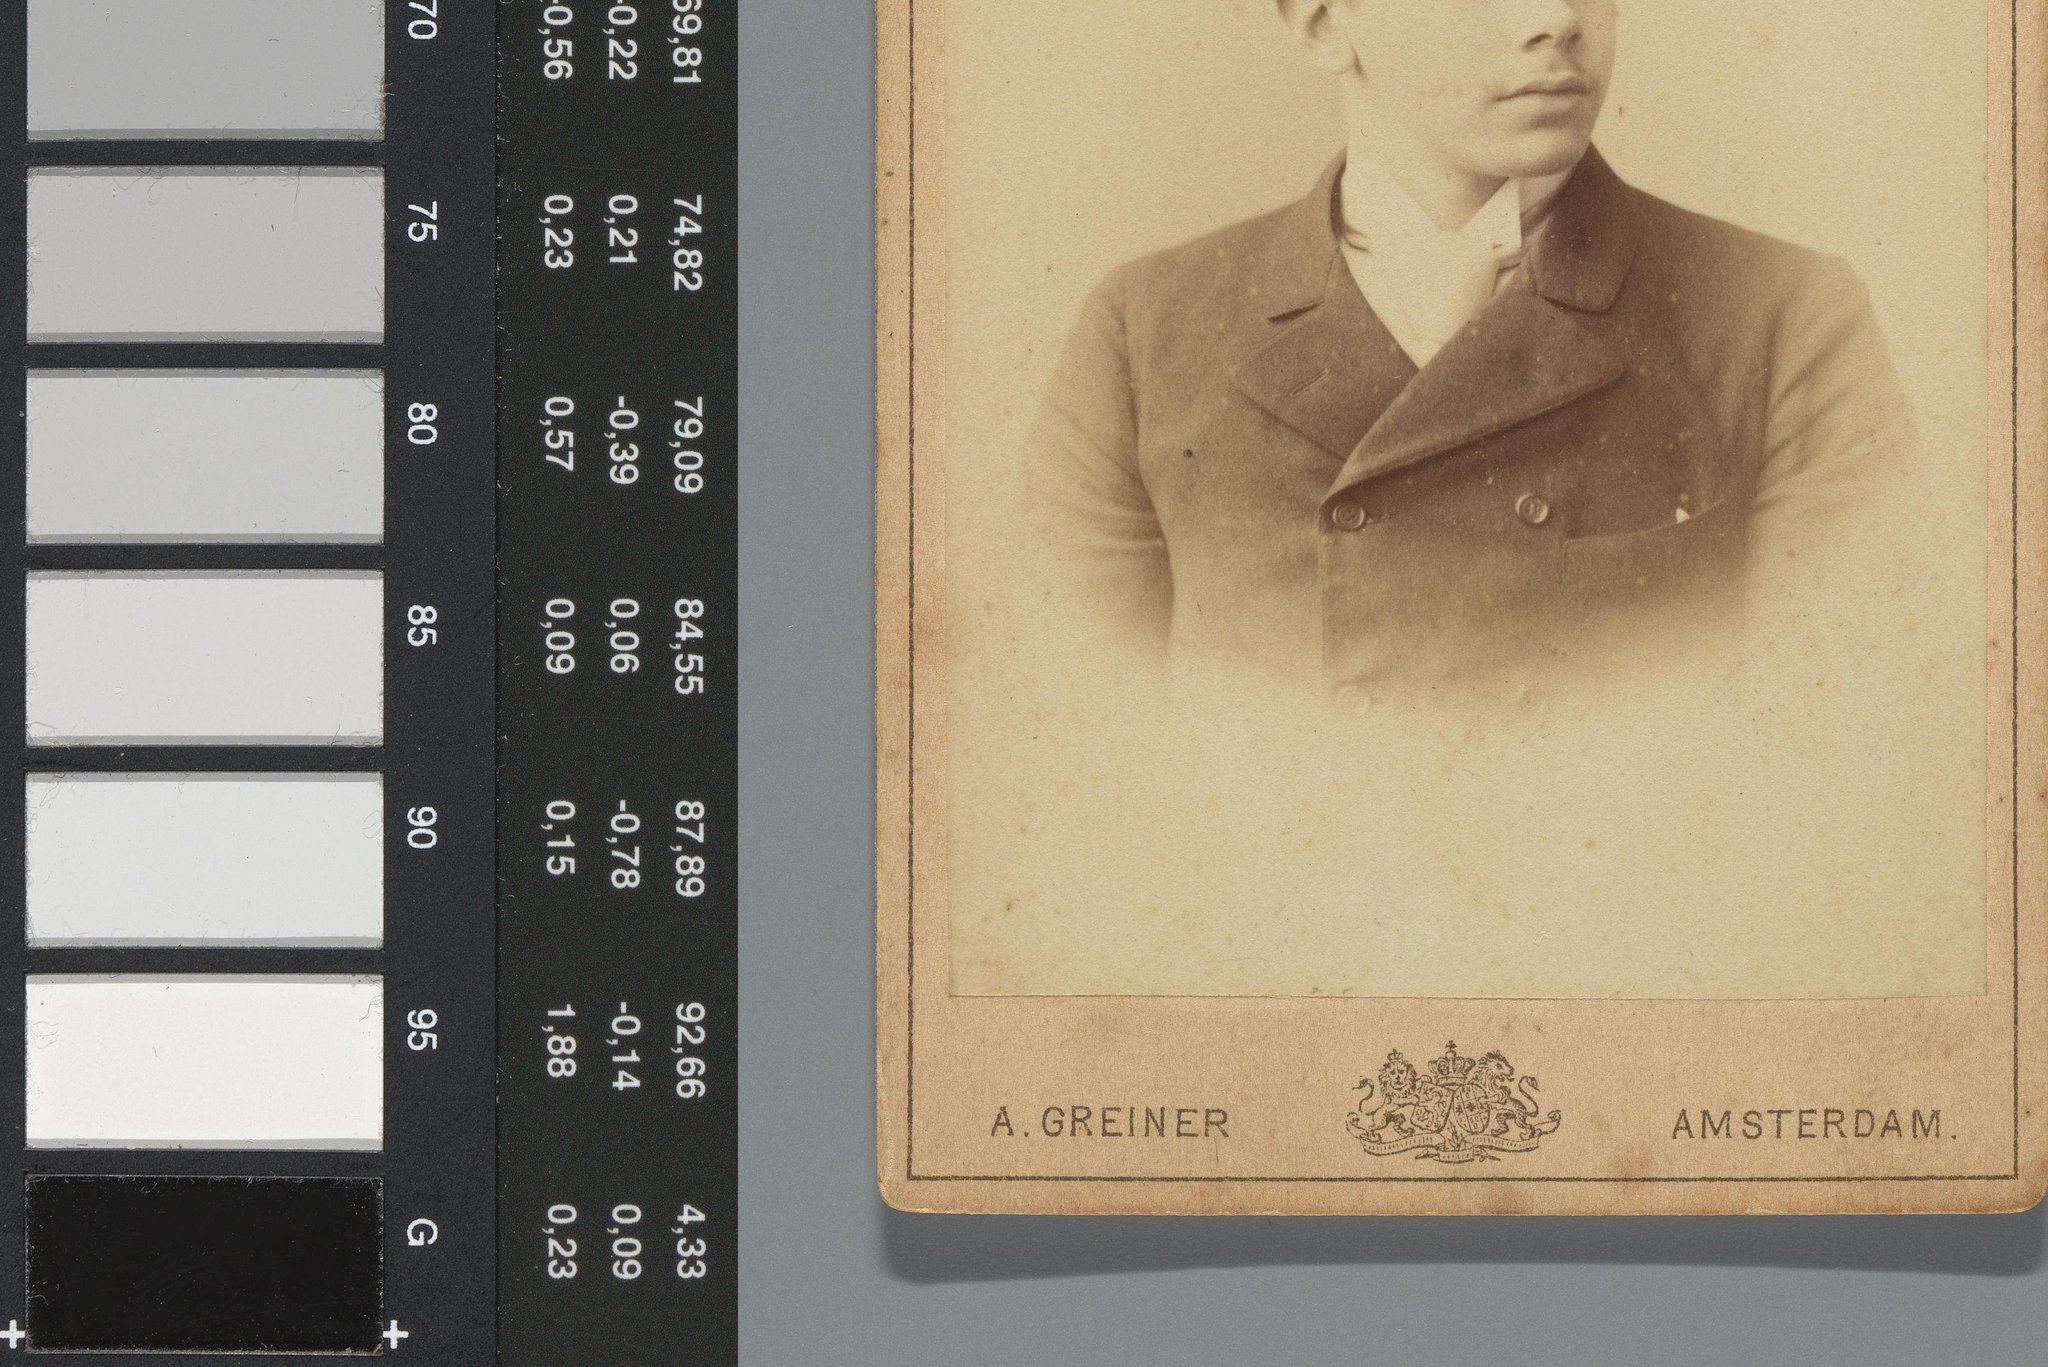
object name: carte de visite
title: Portret van Hendrik Herman van den Berg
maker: albert greiner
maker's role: fotograaf, fotostudio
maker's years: 1833-1890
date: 1885-1890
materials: cardboard, photographic support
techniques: albumen print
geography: amsterdam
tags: batavia, hendrik herman van den berg, amsterdam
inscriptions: name: ‘ALBERT GREINER / KON. NED. HOF-PHOTOGRAAF / AMSTERDAM / NIEUWENDIJK 89. / Specialiteit in Vergrootingen.’, inscription: ‘Henk’, name: ‘A. GREINER AMSTERDAM.’